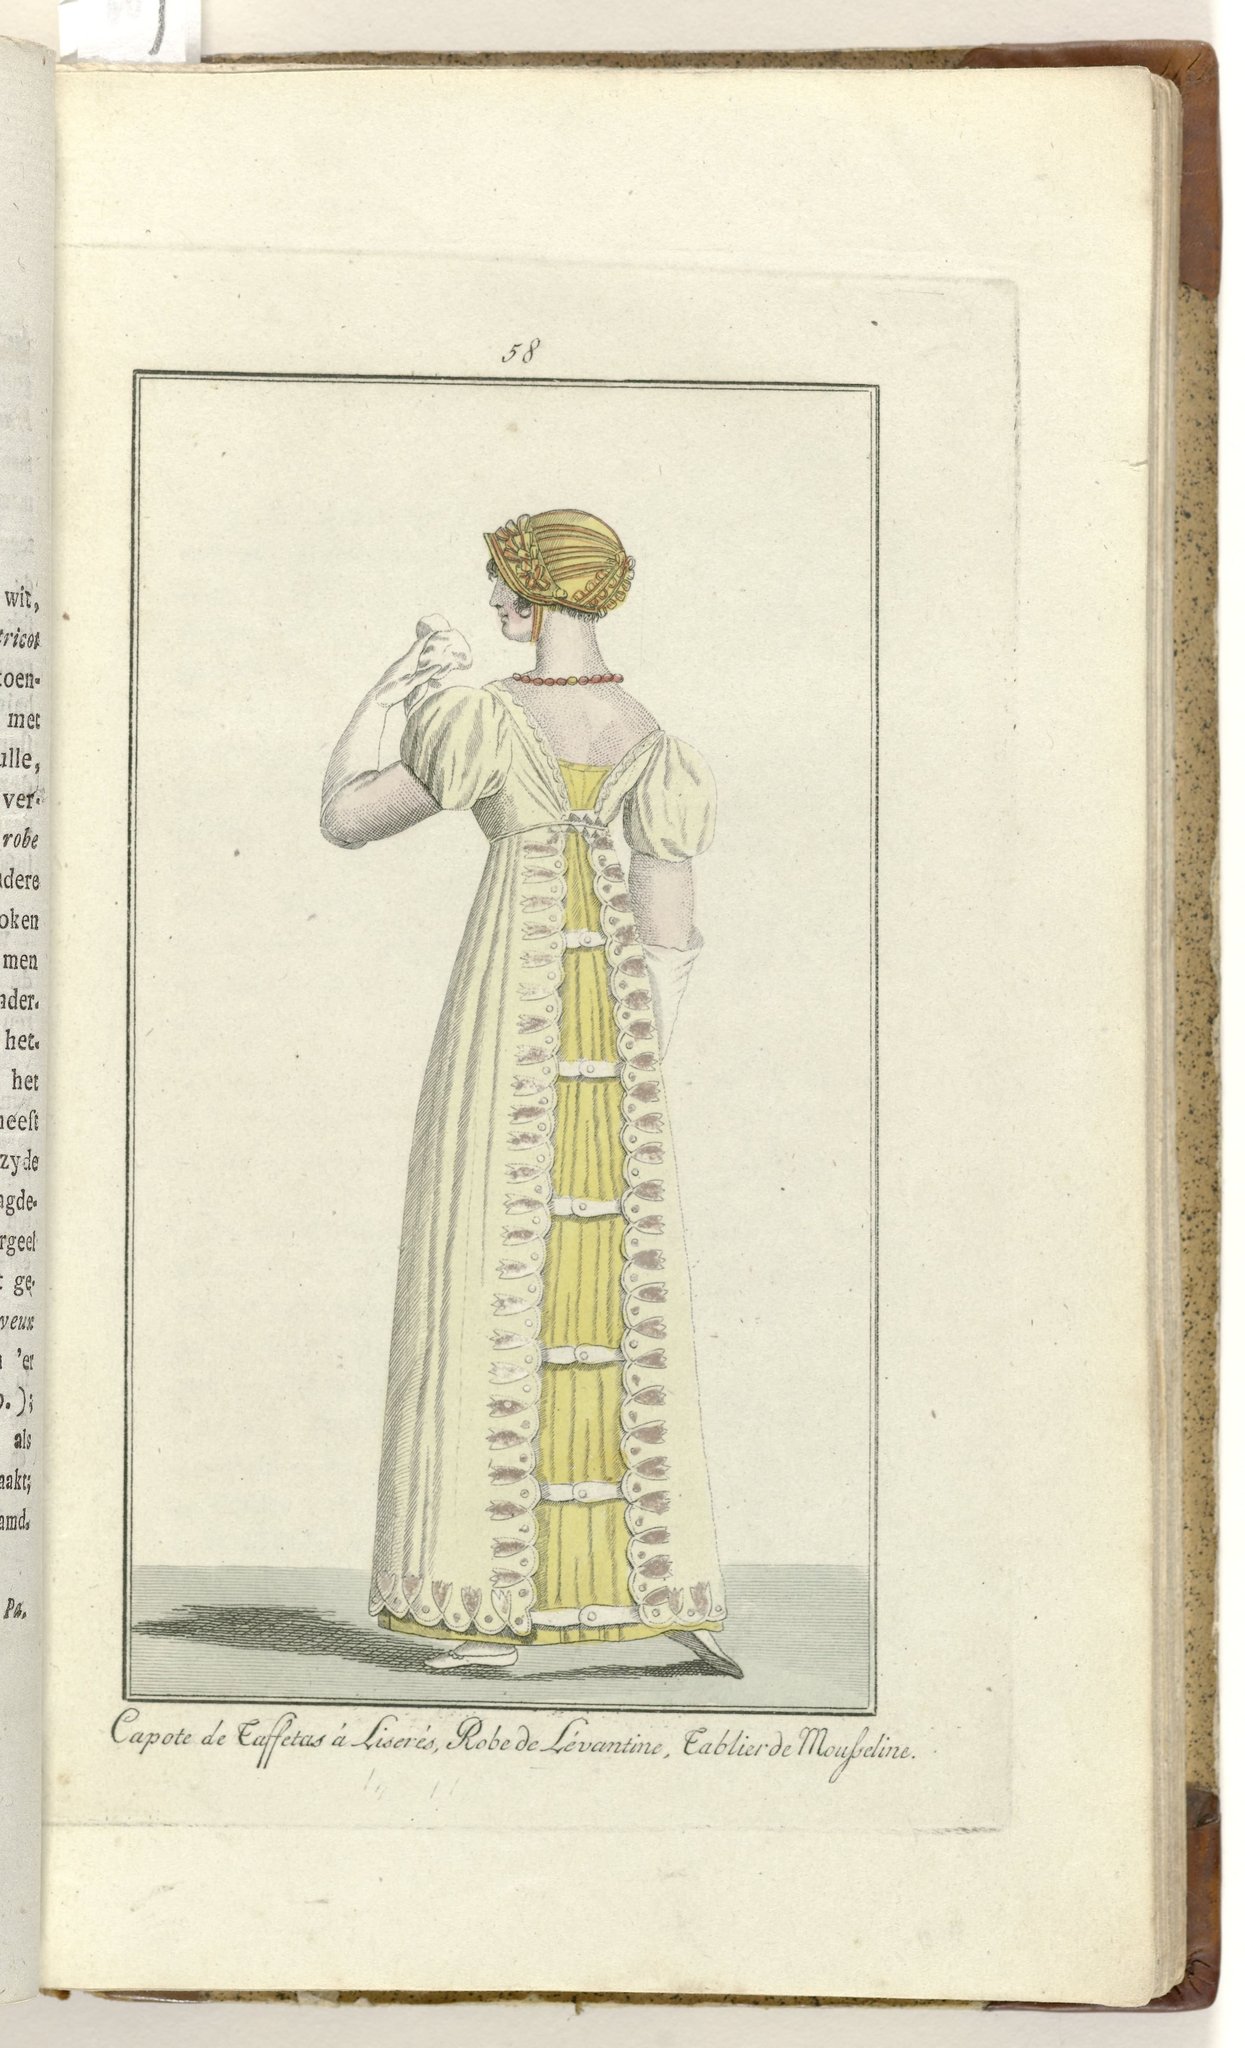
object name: magazine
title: Elegantia, of tijdschrift van mode, luxe en smaak voor dames, Oktober 1808, No. 58: Capote de Taffetas...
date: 1808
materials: paper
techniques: engraving, hand coloring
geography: amsterdam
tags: handkerchief (+ women's clothes), gloves, mittens (long gloves) (+ women's clothes), fashion plates, head-gear: hat (+ women's clothes), dress, gown (+ women's clothes), apron (+ women's clothes)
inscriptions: caption: ‘Capote de Taffetas à Liserés, Robe de Lévantine, Tablier de Mousseline.’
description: Volgens de begeleidende tekst (p. 320): Japon van gele 'lévantine. 'Tablier' (schort) van mousseline. Capote van gele zijde met liserés. Prent uit het modetijdschrift Elegantia, of tijdschrift van mode, luxe en smaak voor dames 1807-1814 (onderbroken door de periode 1811-1813).